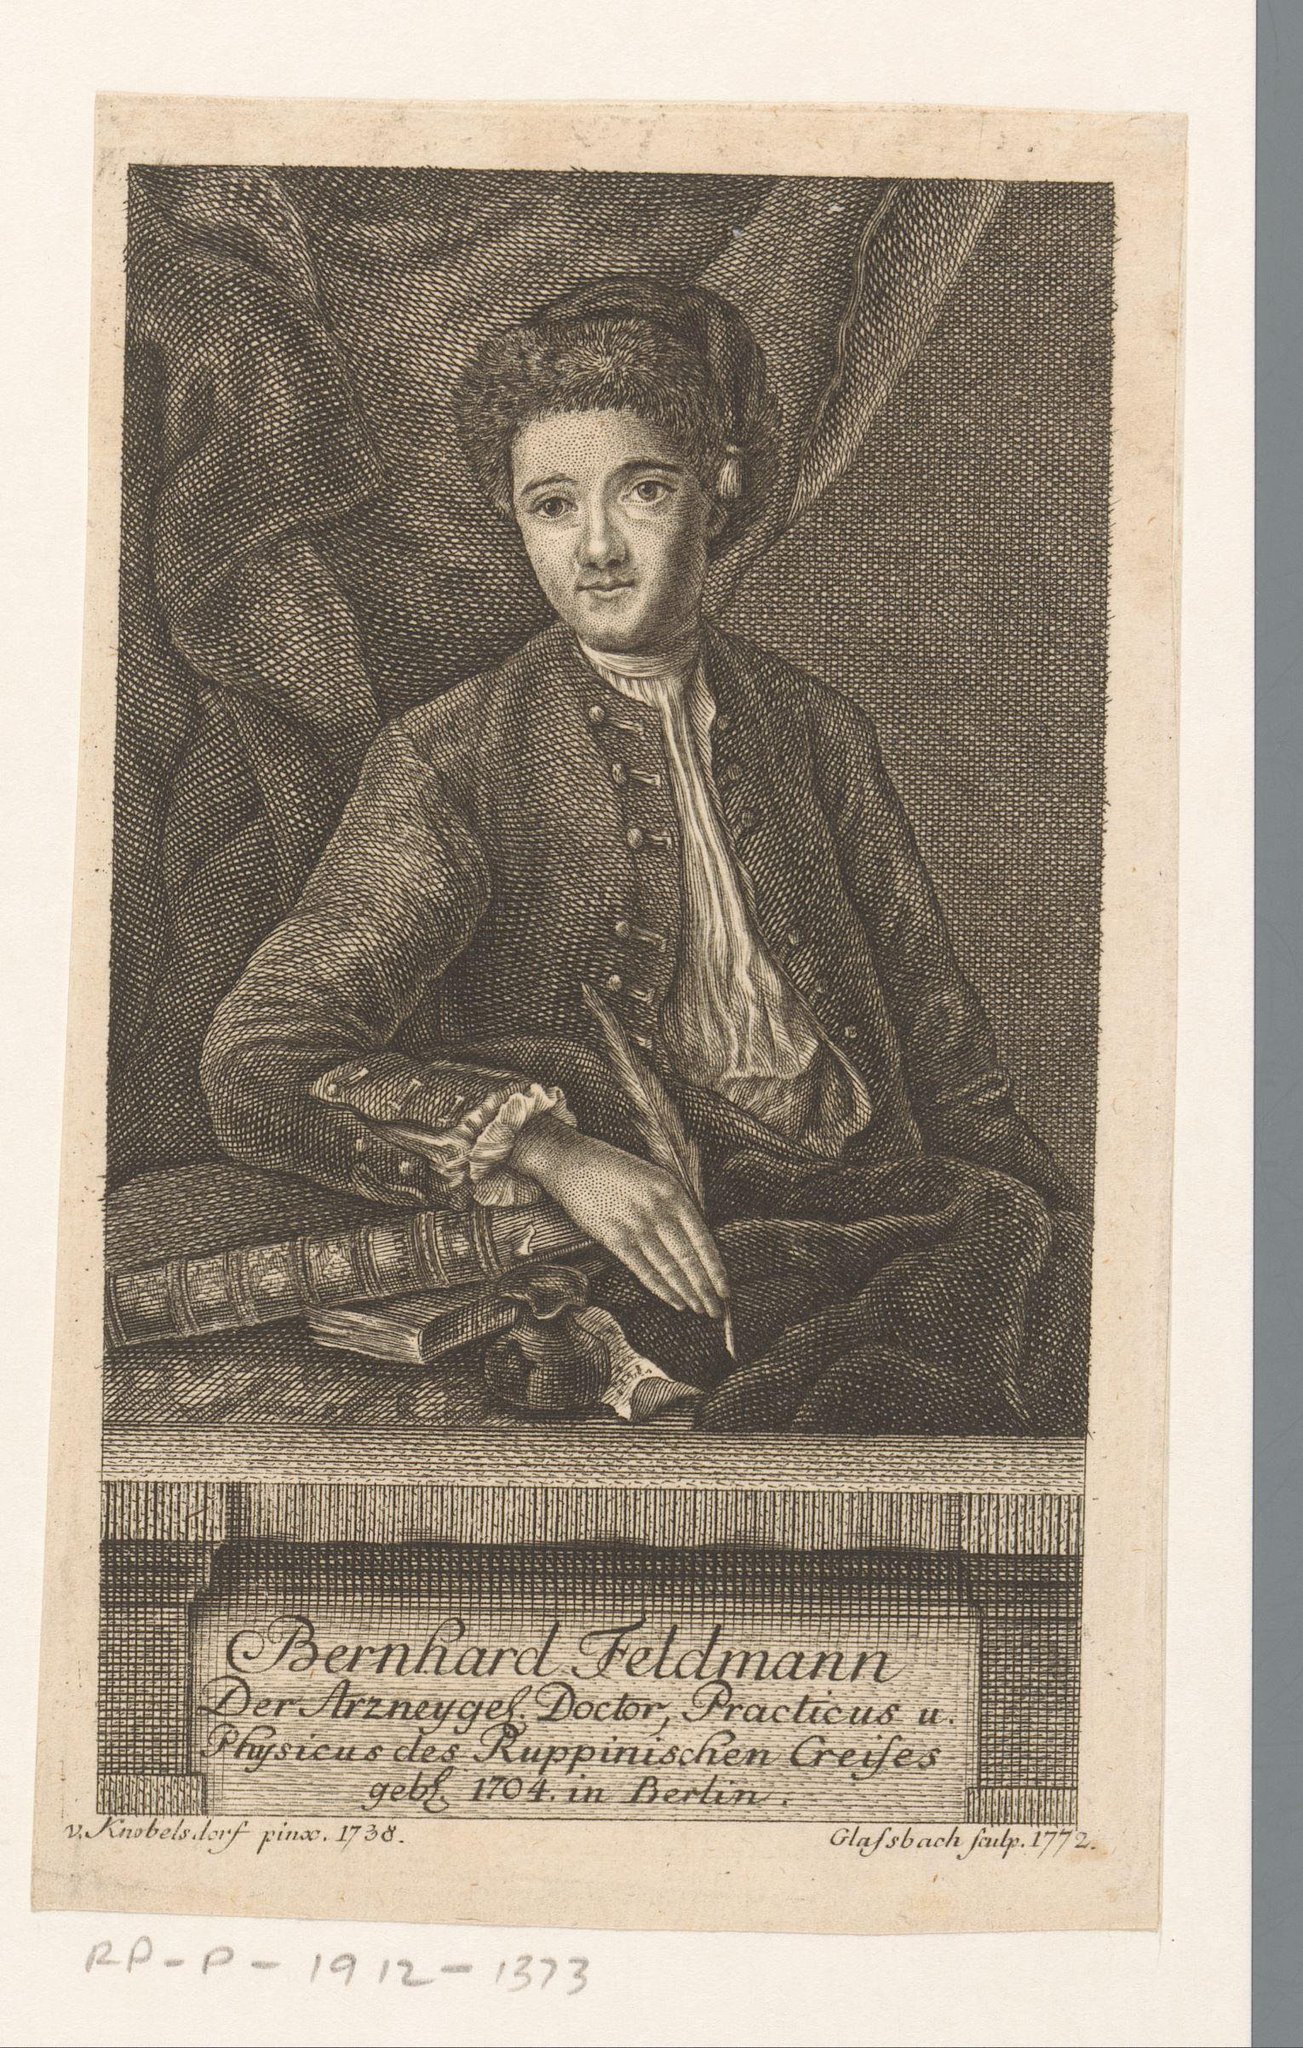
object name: print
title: Portret van Bernhard Feldmann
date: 1738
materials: paper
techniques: engraving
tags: writing tools, historical persons, physician, doctor, book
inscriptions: collector's mark: Lugt 2228